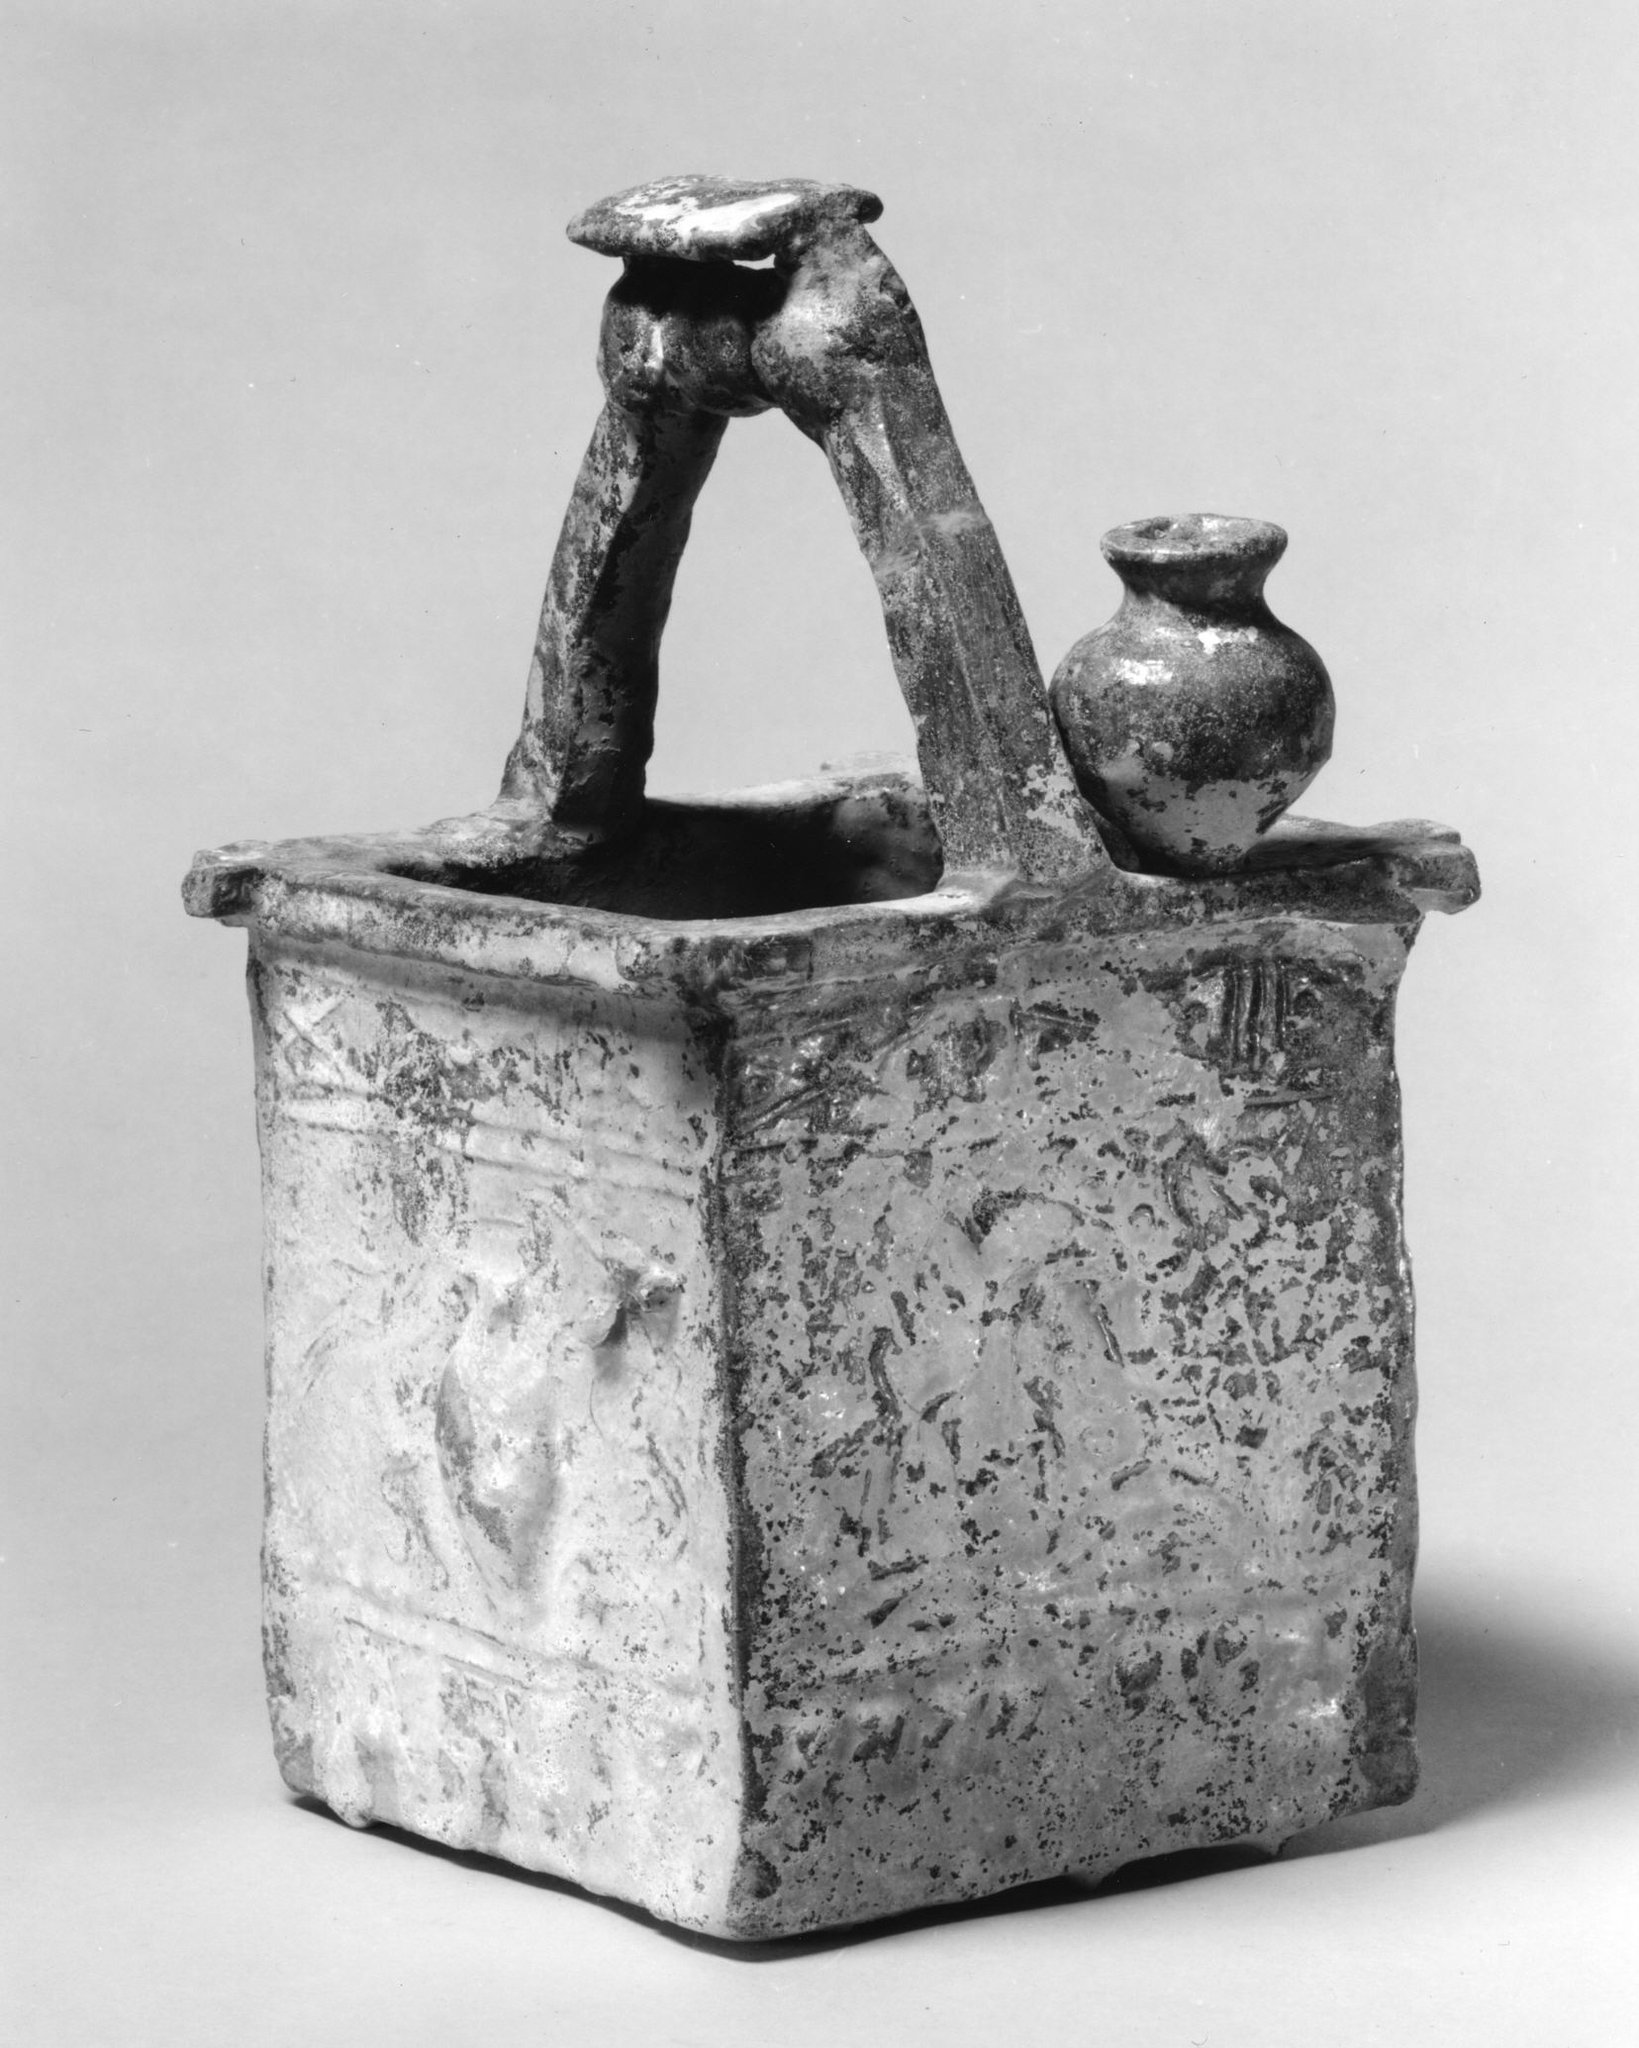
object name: architectural model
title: Wellhead with Bucket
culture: chinese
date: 25-220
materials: earthenware, glaze